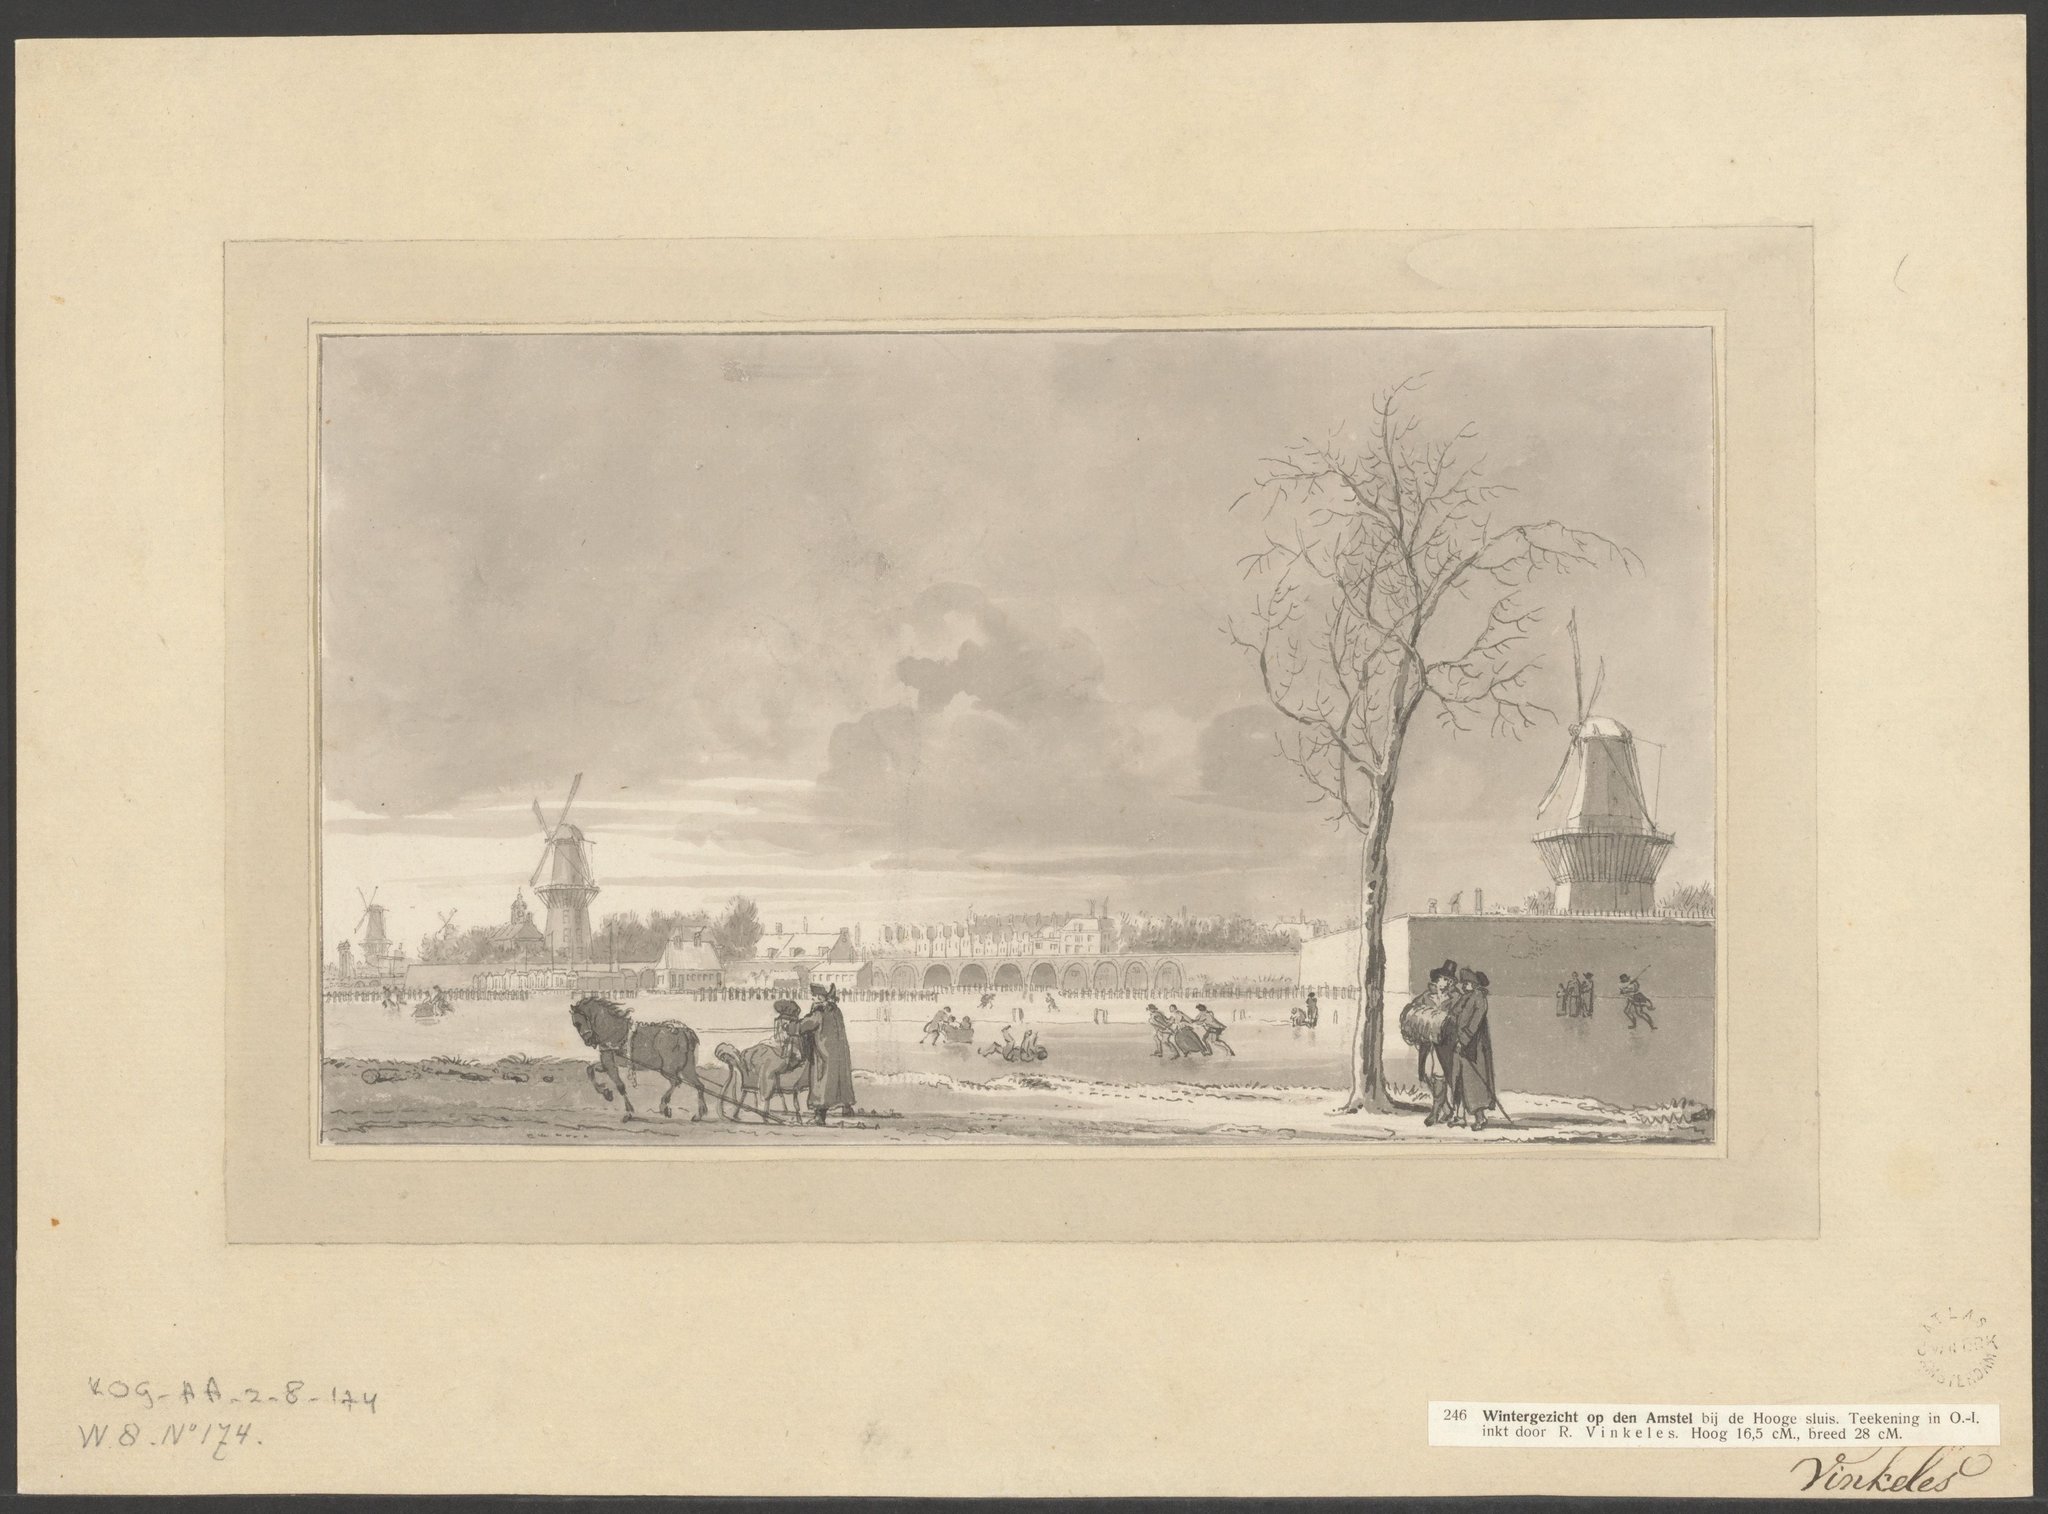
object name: drawing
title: Wintergezicht bij de Hogesluis, gezien vanaf de Weesperzijde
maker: reinier vinkeles (i)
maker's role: draughtsman, print maker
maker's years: 1741-1816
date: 1751-1816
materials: ink, paper, pencil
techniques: brush, pen, snipping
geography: amsterdam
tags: city-view in general; 'veduta', river, winter landscape; landscape symbolizing winter (the four seasons of the year), bridge in city across river, canal, etc., windmill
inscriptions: name: ‘Vinkeles’, collector's mark: Lugt 800a, : ‘246 Wintergezicht op (...) breed 28 cM.’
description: Tekening binnen de Atlas Van Eck ingedeeld op wijknummer 8.